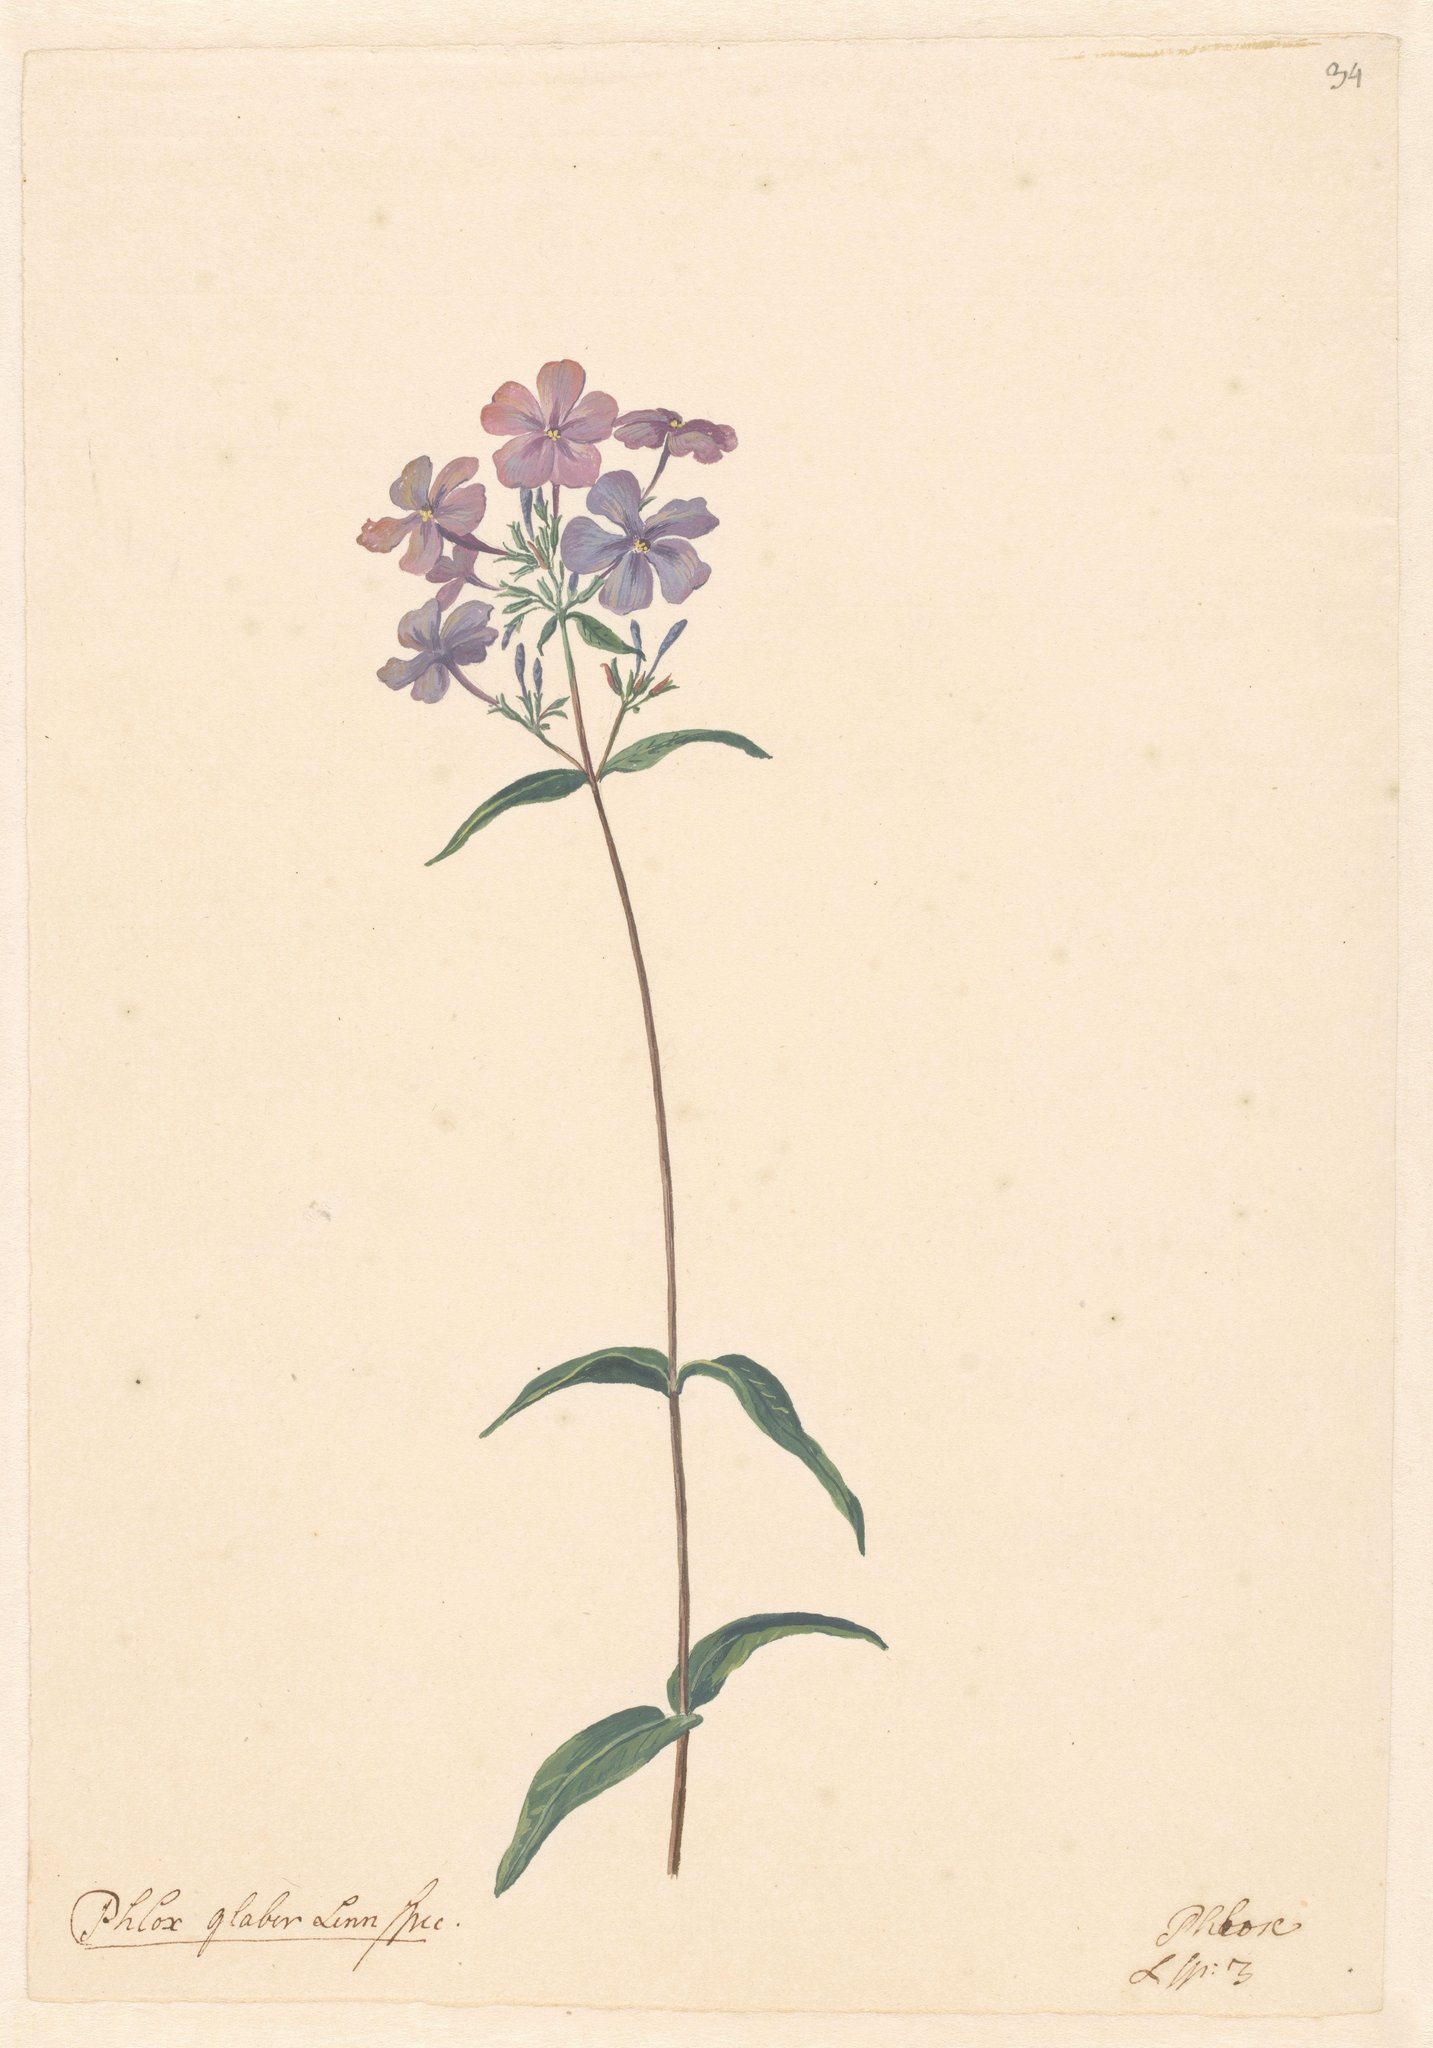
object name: drawing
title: Tak van een flox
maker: willem van leen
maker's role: draughtsman, print maker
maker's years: 1753-1825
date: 1775-1825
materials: gouache, pencil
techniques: brush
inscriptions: inscription: ‘34’, annotation: ‘Phlox glaber Linn’